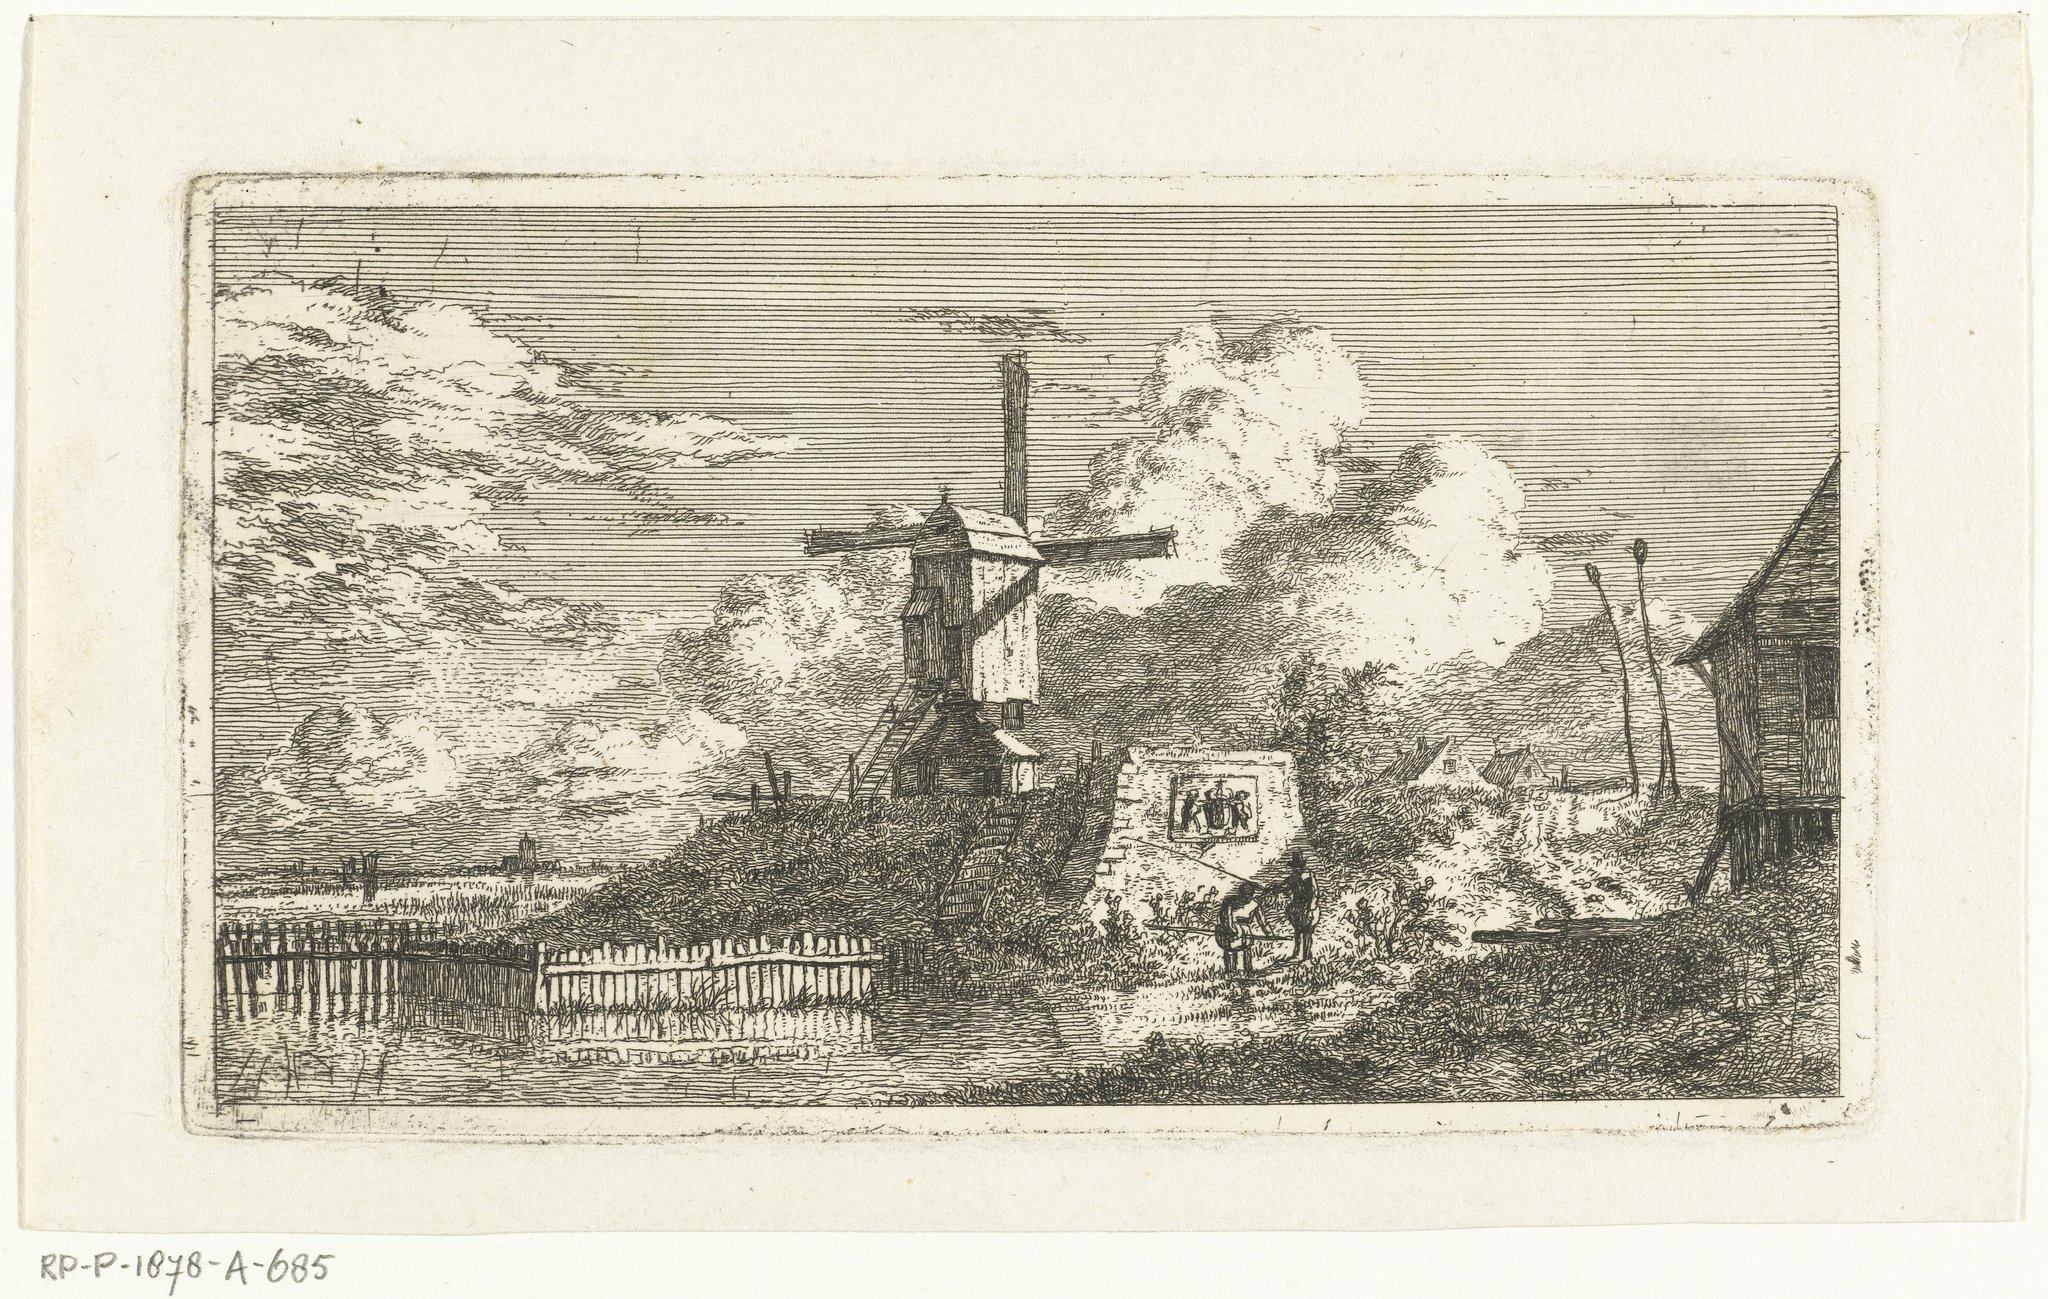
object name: print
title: Landschap met molen op terp aan water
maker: albertus brondgeest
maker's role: draughtsman, print maker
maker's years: 1786-1849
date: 1796-1849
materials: paper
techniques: etching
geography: netherlands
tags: windmill in landscape, windmill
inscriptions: collector's mark: Lugt 2228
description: Landschap met een houten molen op een terp aan het water. Op een stenen muur staat het wapen van de stad Amsterdam. Twee vissers staan op de oever met hengels.